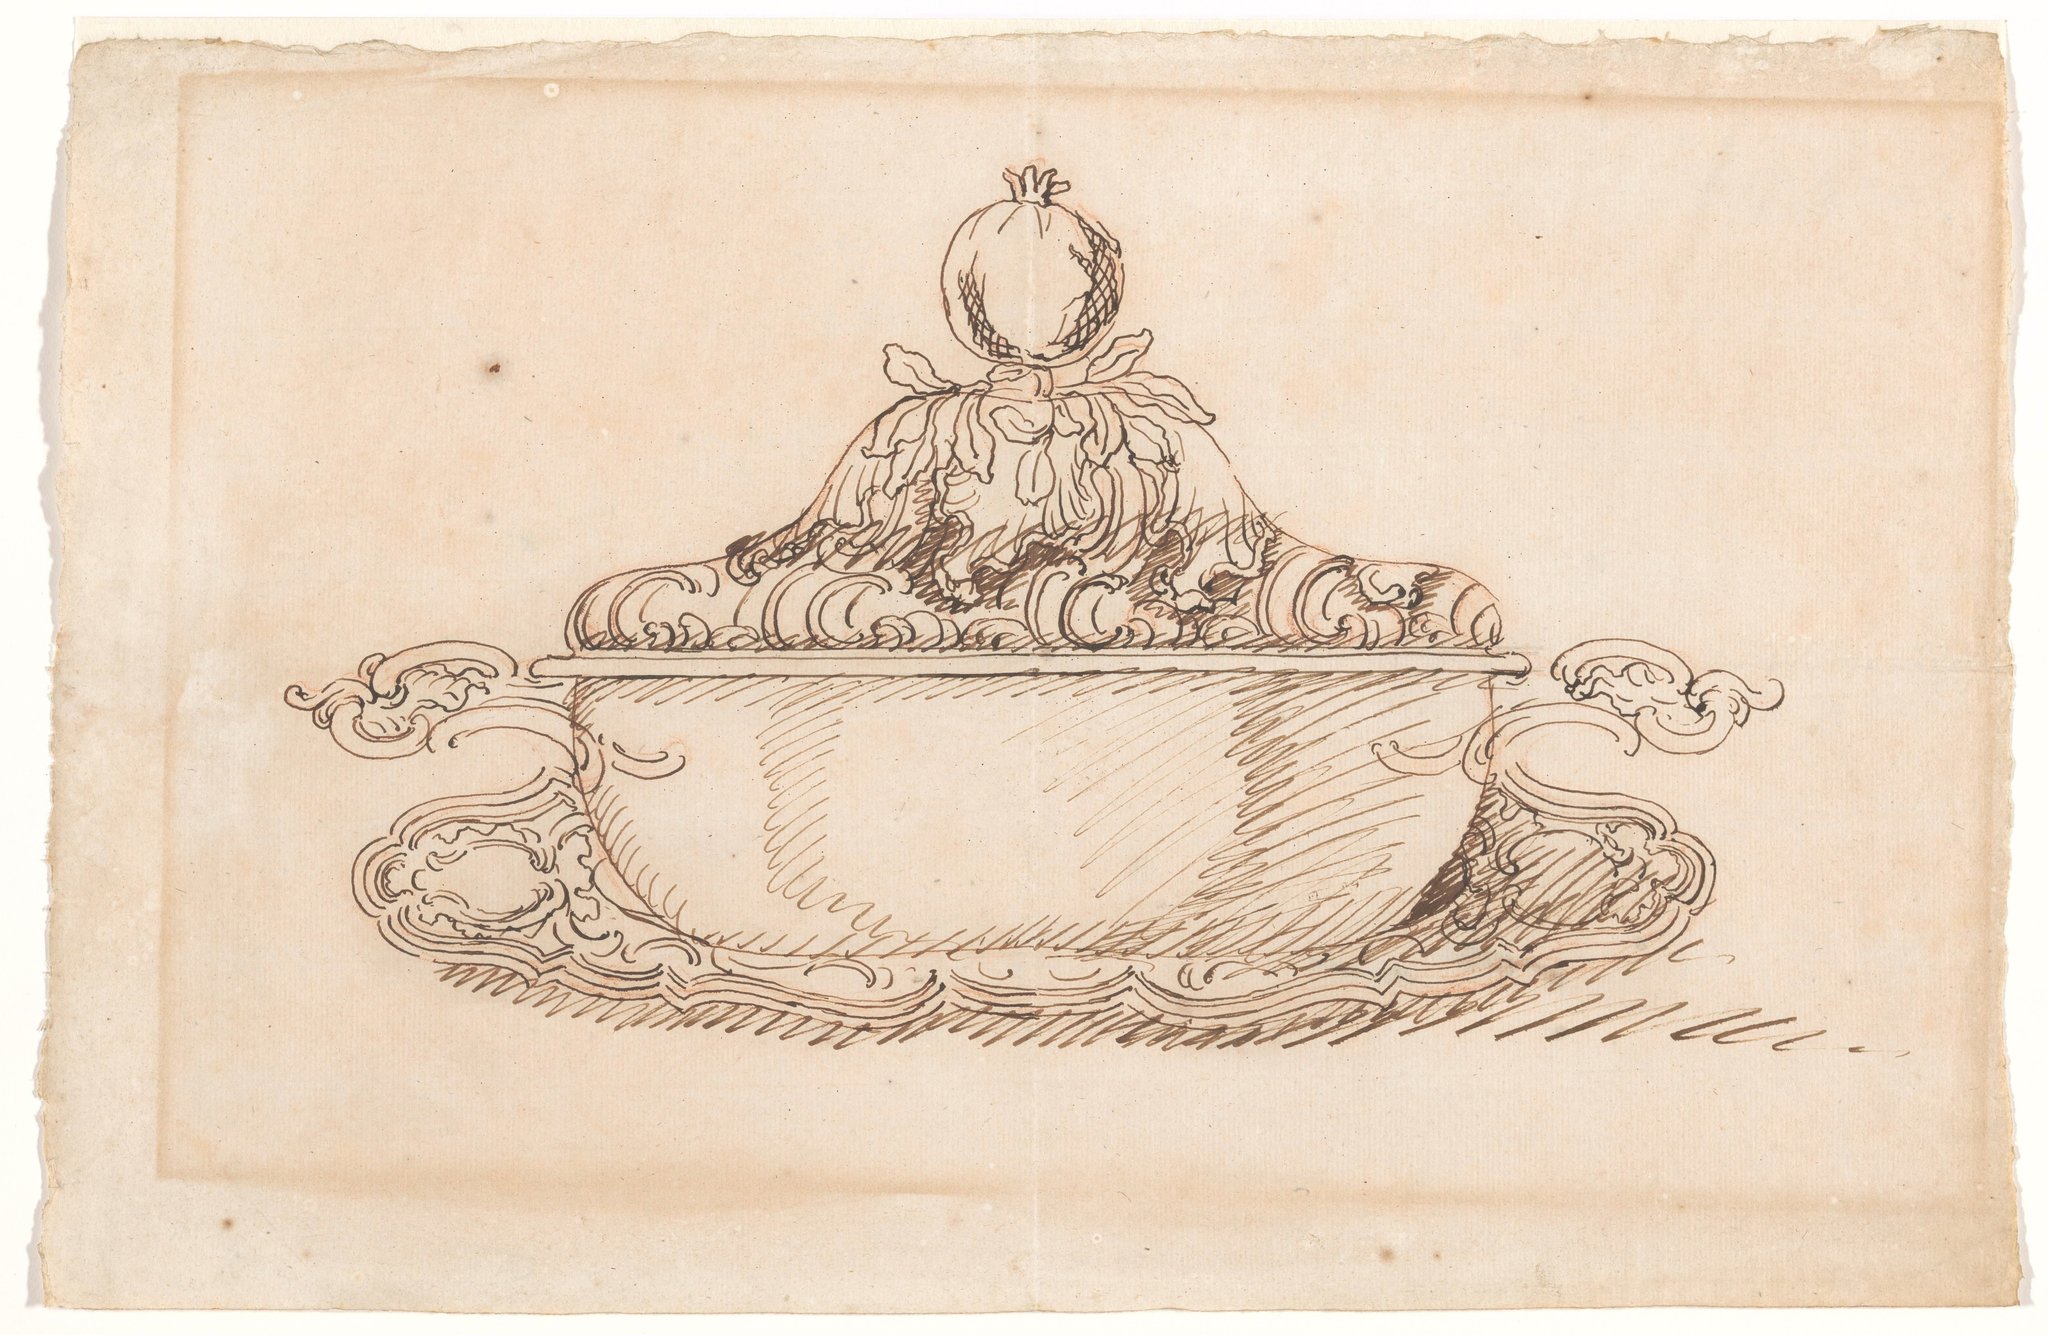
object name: drawing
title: Ronde dekschaal op gecontourneerde onderschotel (écuelle) met een door een granaatappel bekroonde deksel.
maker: Anonymous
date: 1750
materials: chalk, graphite, ink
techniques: drawing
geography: france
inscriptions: watermark: ‘klavertje vier onder kroon met lelie?’